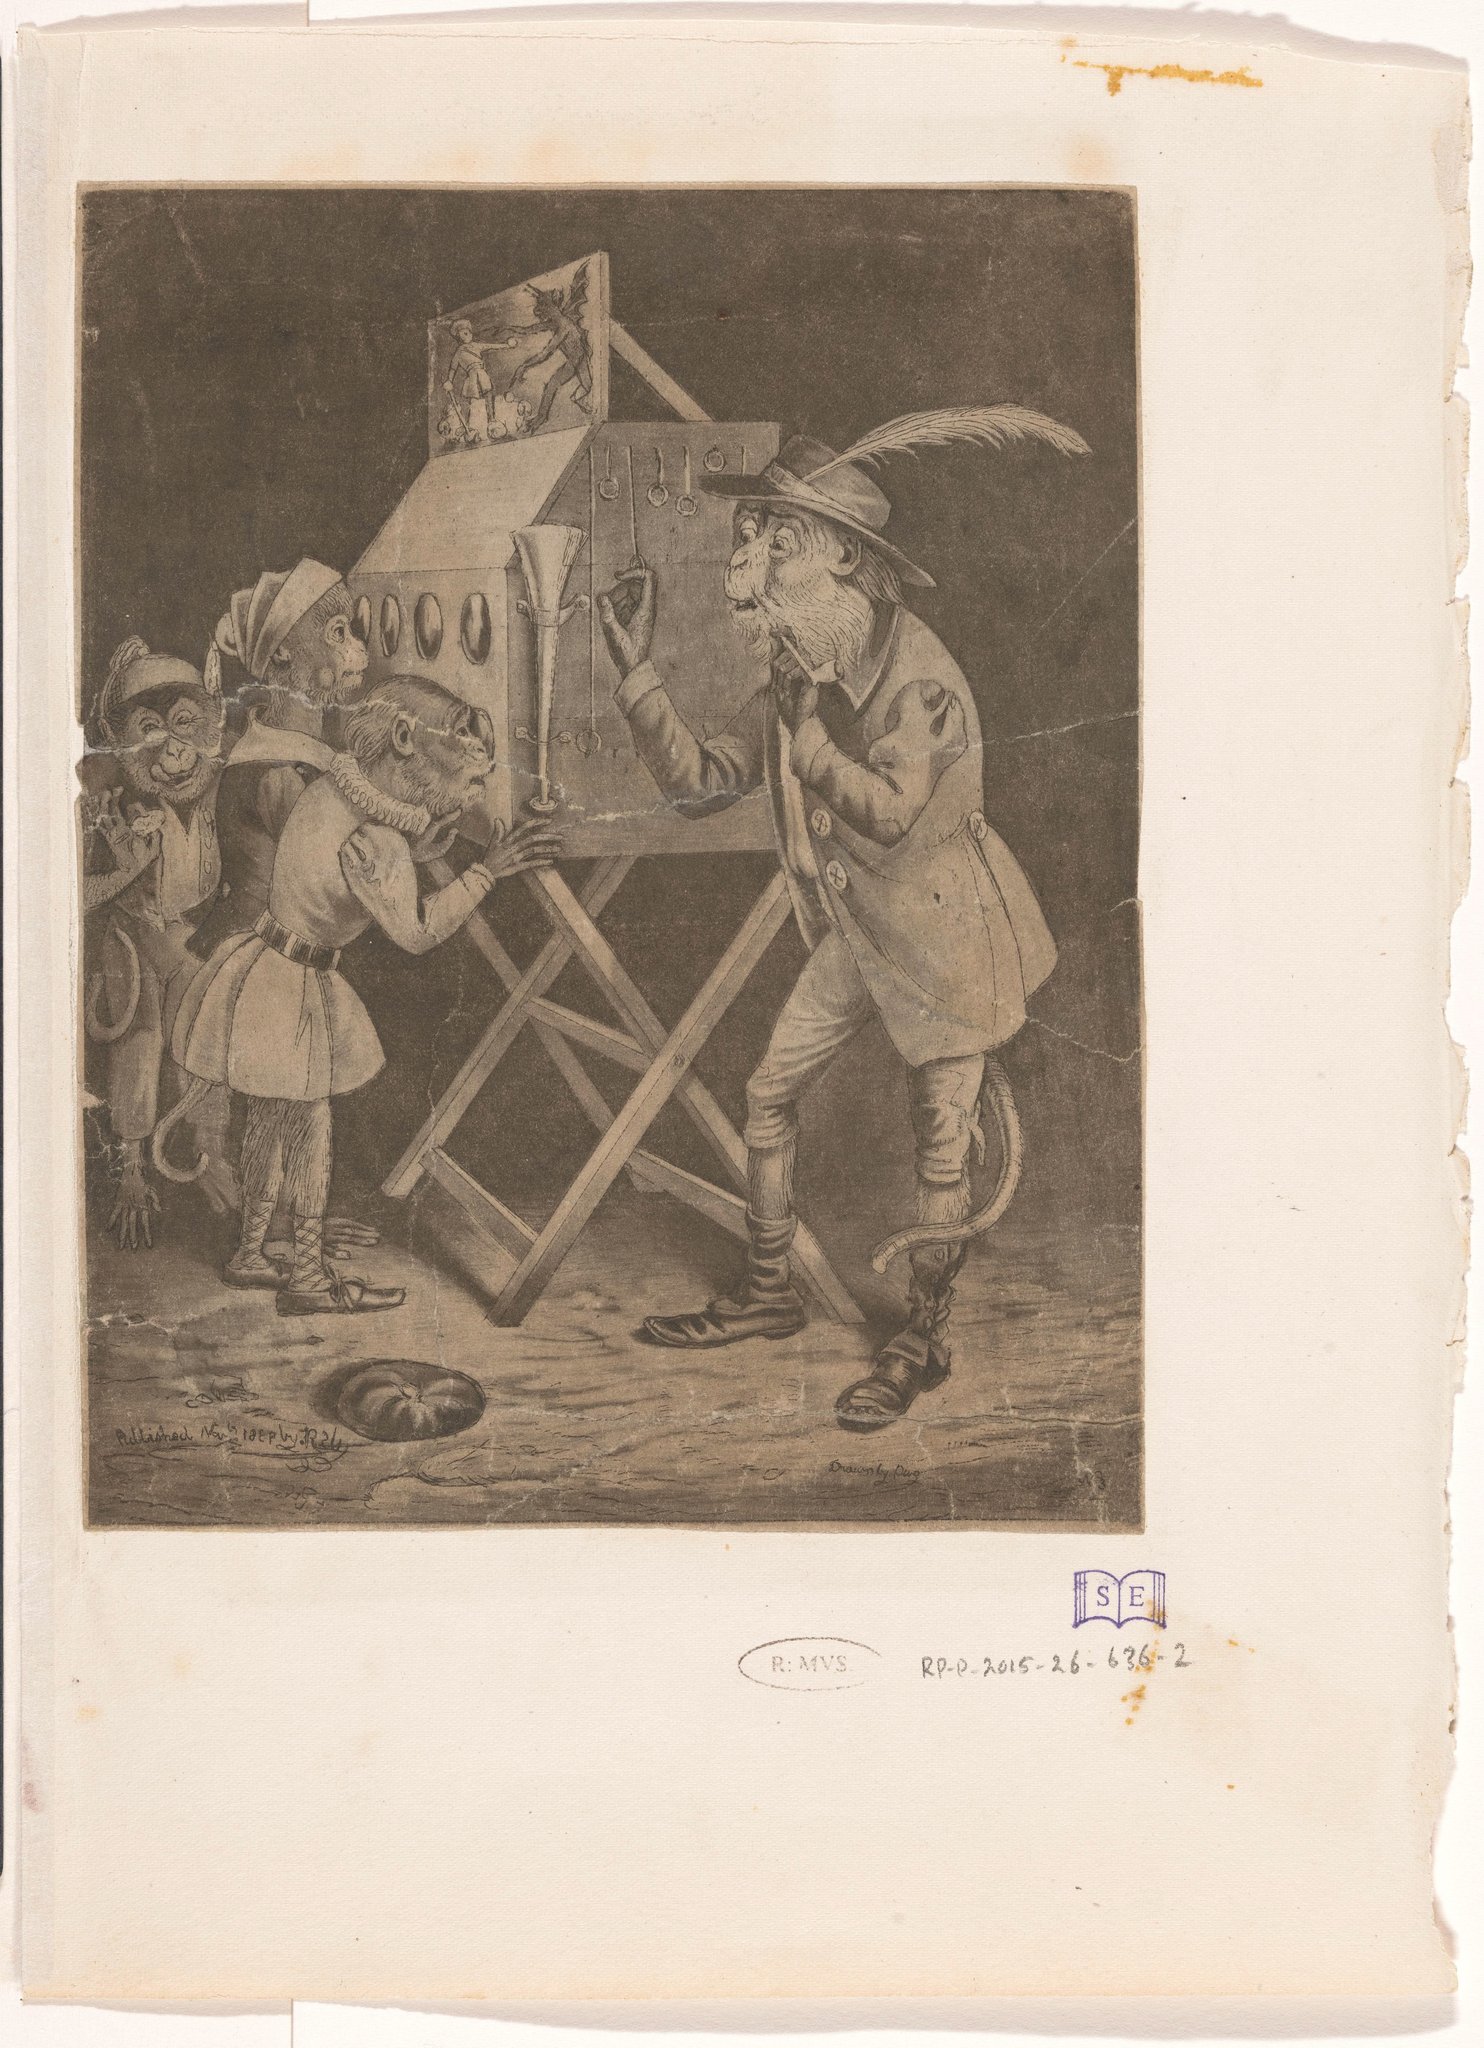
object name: print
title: Kijkkast met apen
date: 1812-1839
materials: paper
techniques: mezzotint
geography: london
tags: monkeys, apes, animals acting as human beings, peep-show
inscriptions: collector's mark: Lugt 4779, collector's mark: Lugt 2228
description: Drie apen in kinderkleding voor een kijkkast op schragen, een trompet aan de zijkant en bovenop een afbeelding van een duivel en een figuur met een zwaard. Naast de kast een aap met een jas en een hoed met een veer, hij trekt aan een van de koorden die uit de kast tevoorschijn komen.